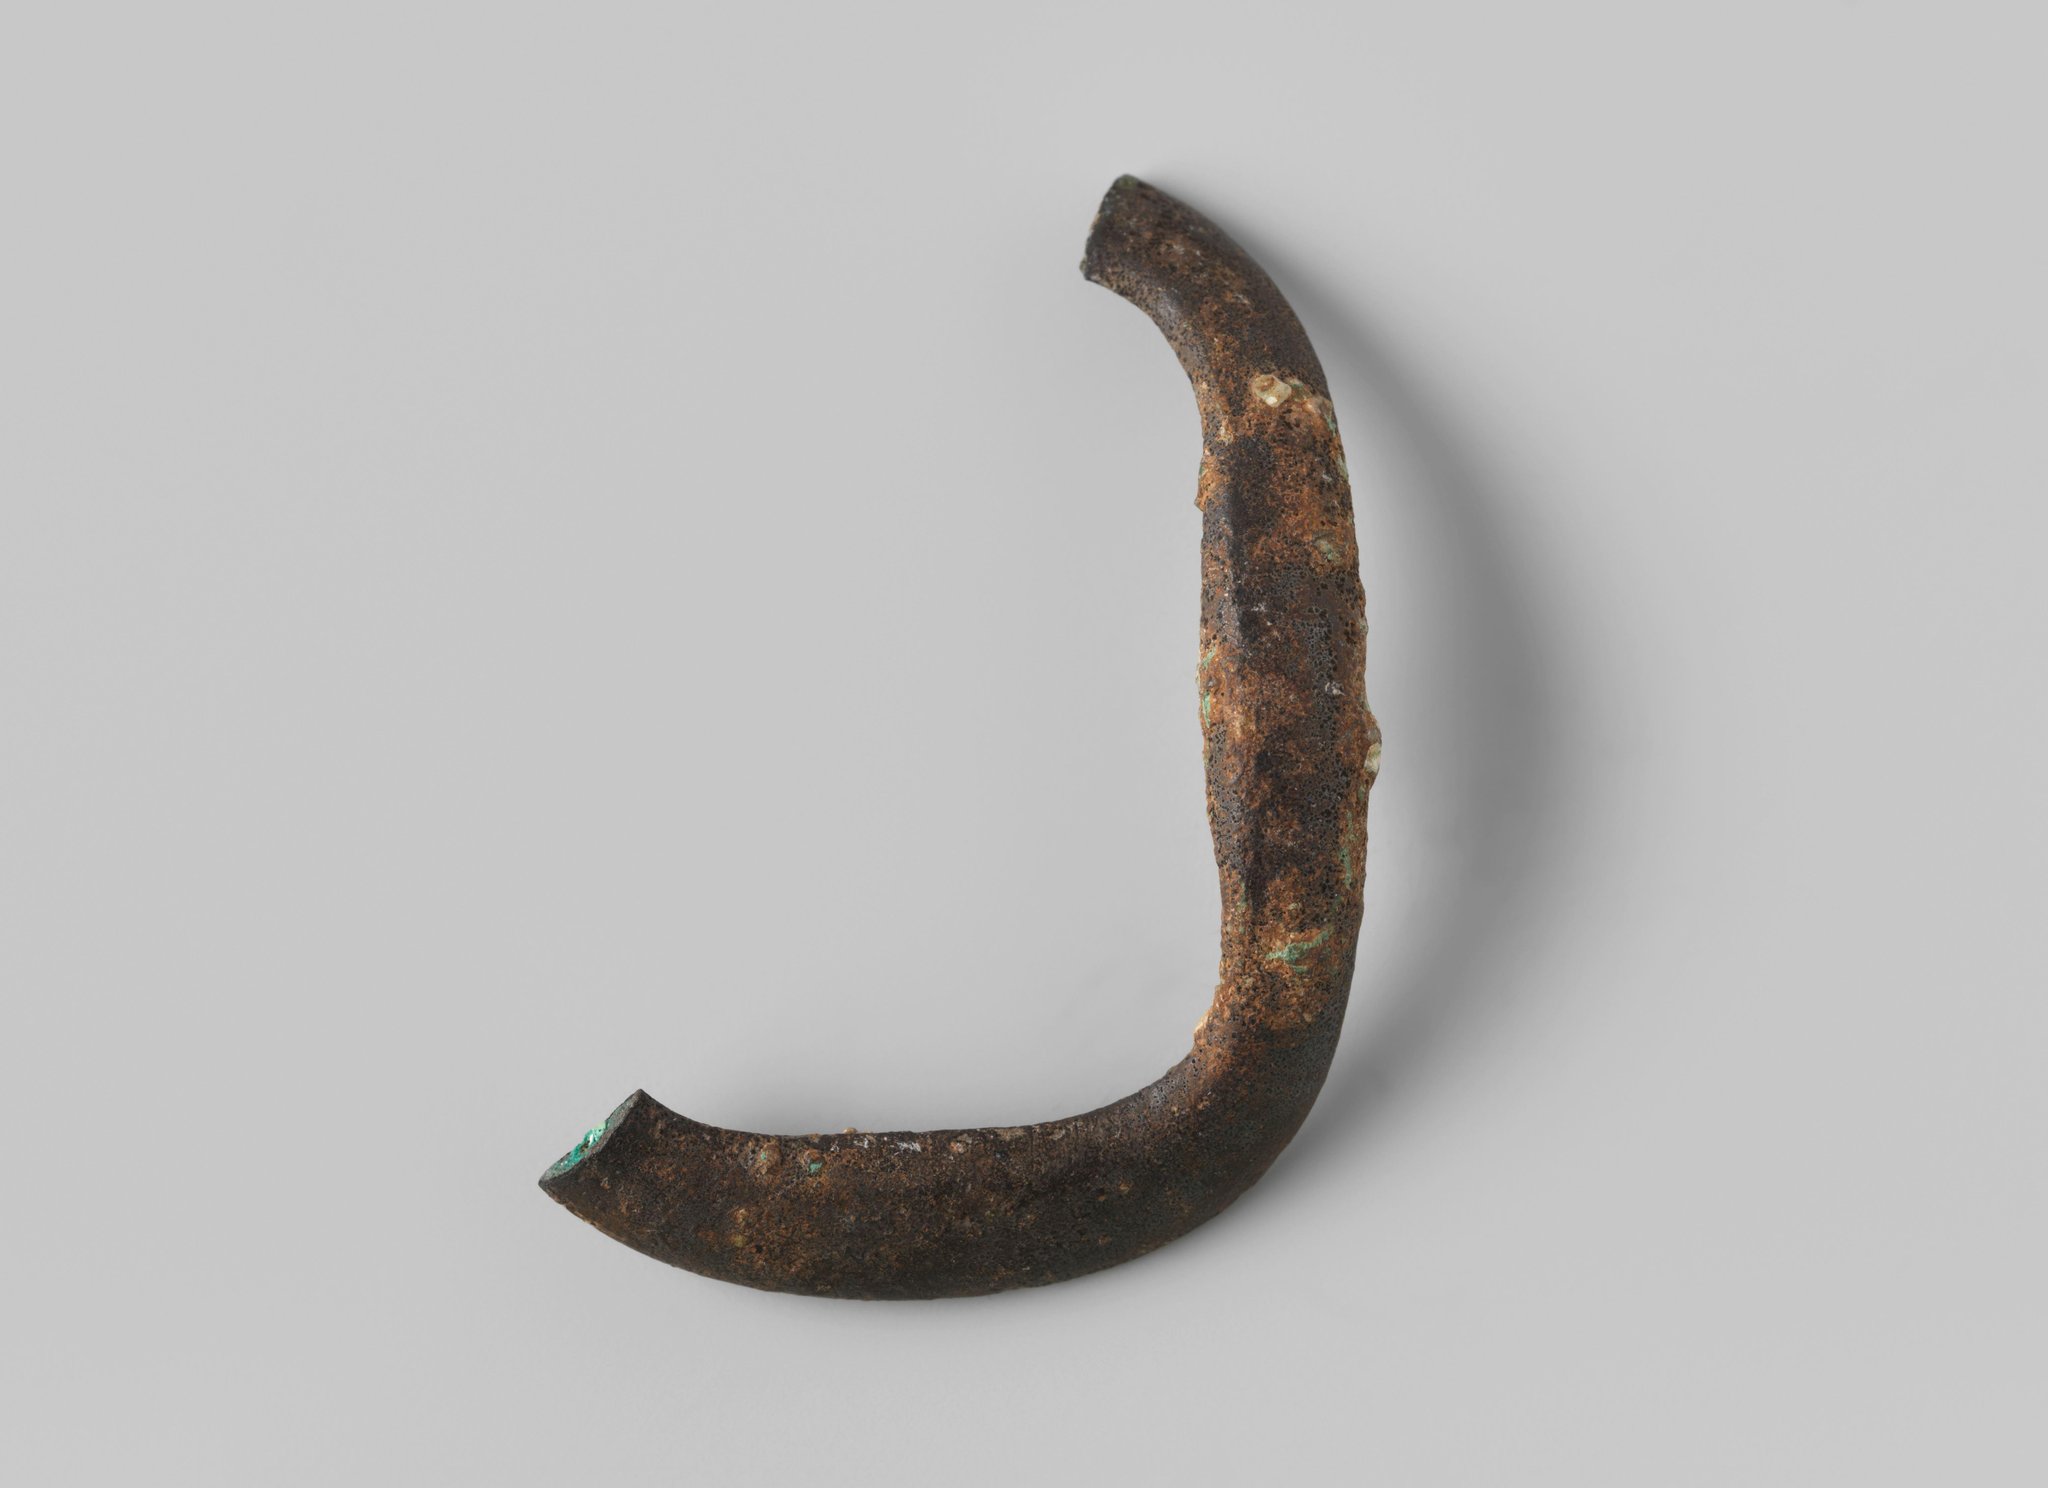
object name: shoe buckle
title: Fragment schoengesp uit het wrak van de Oost-Indiëvaarder Hollandia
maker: Anonymous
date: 1700-1743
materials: copper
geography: netherlands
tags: verenigde oostindische compagnie, hollandia (schip), annet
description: Buckle, chape buckle, shoe buckle; fragment of ring, id. NG 1980-27H1340.